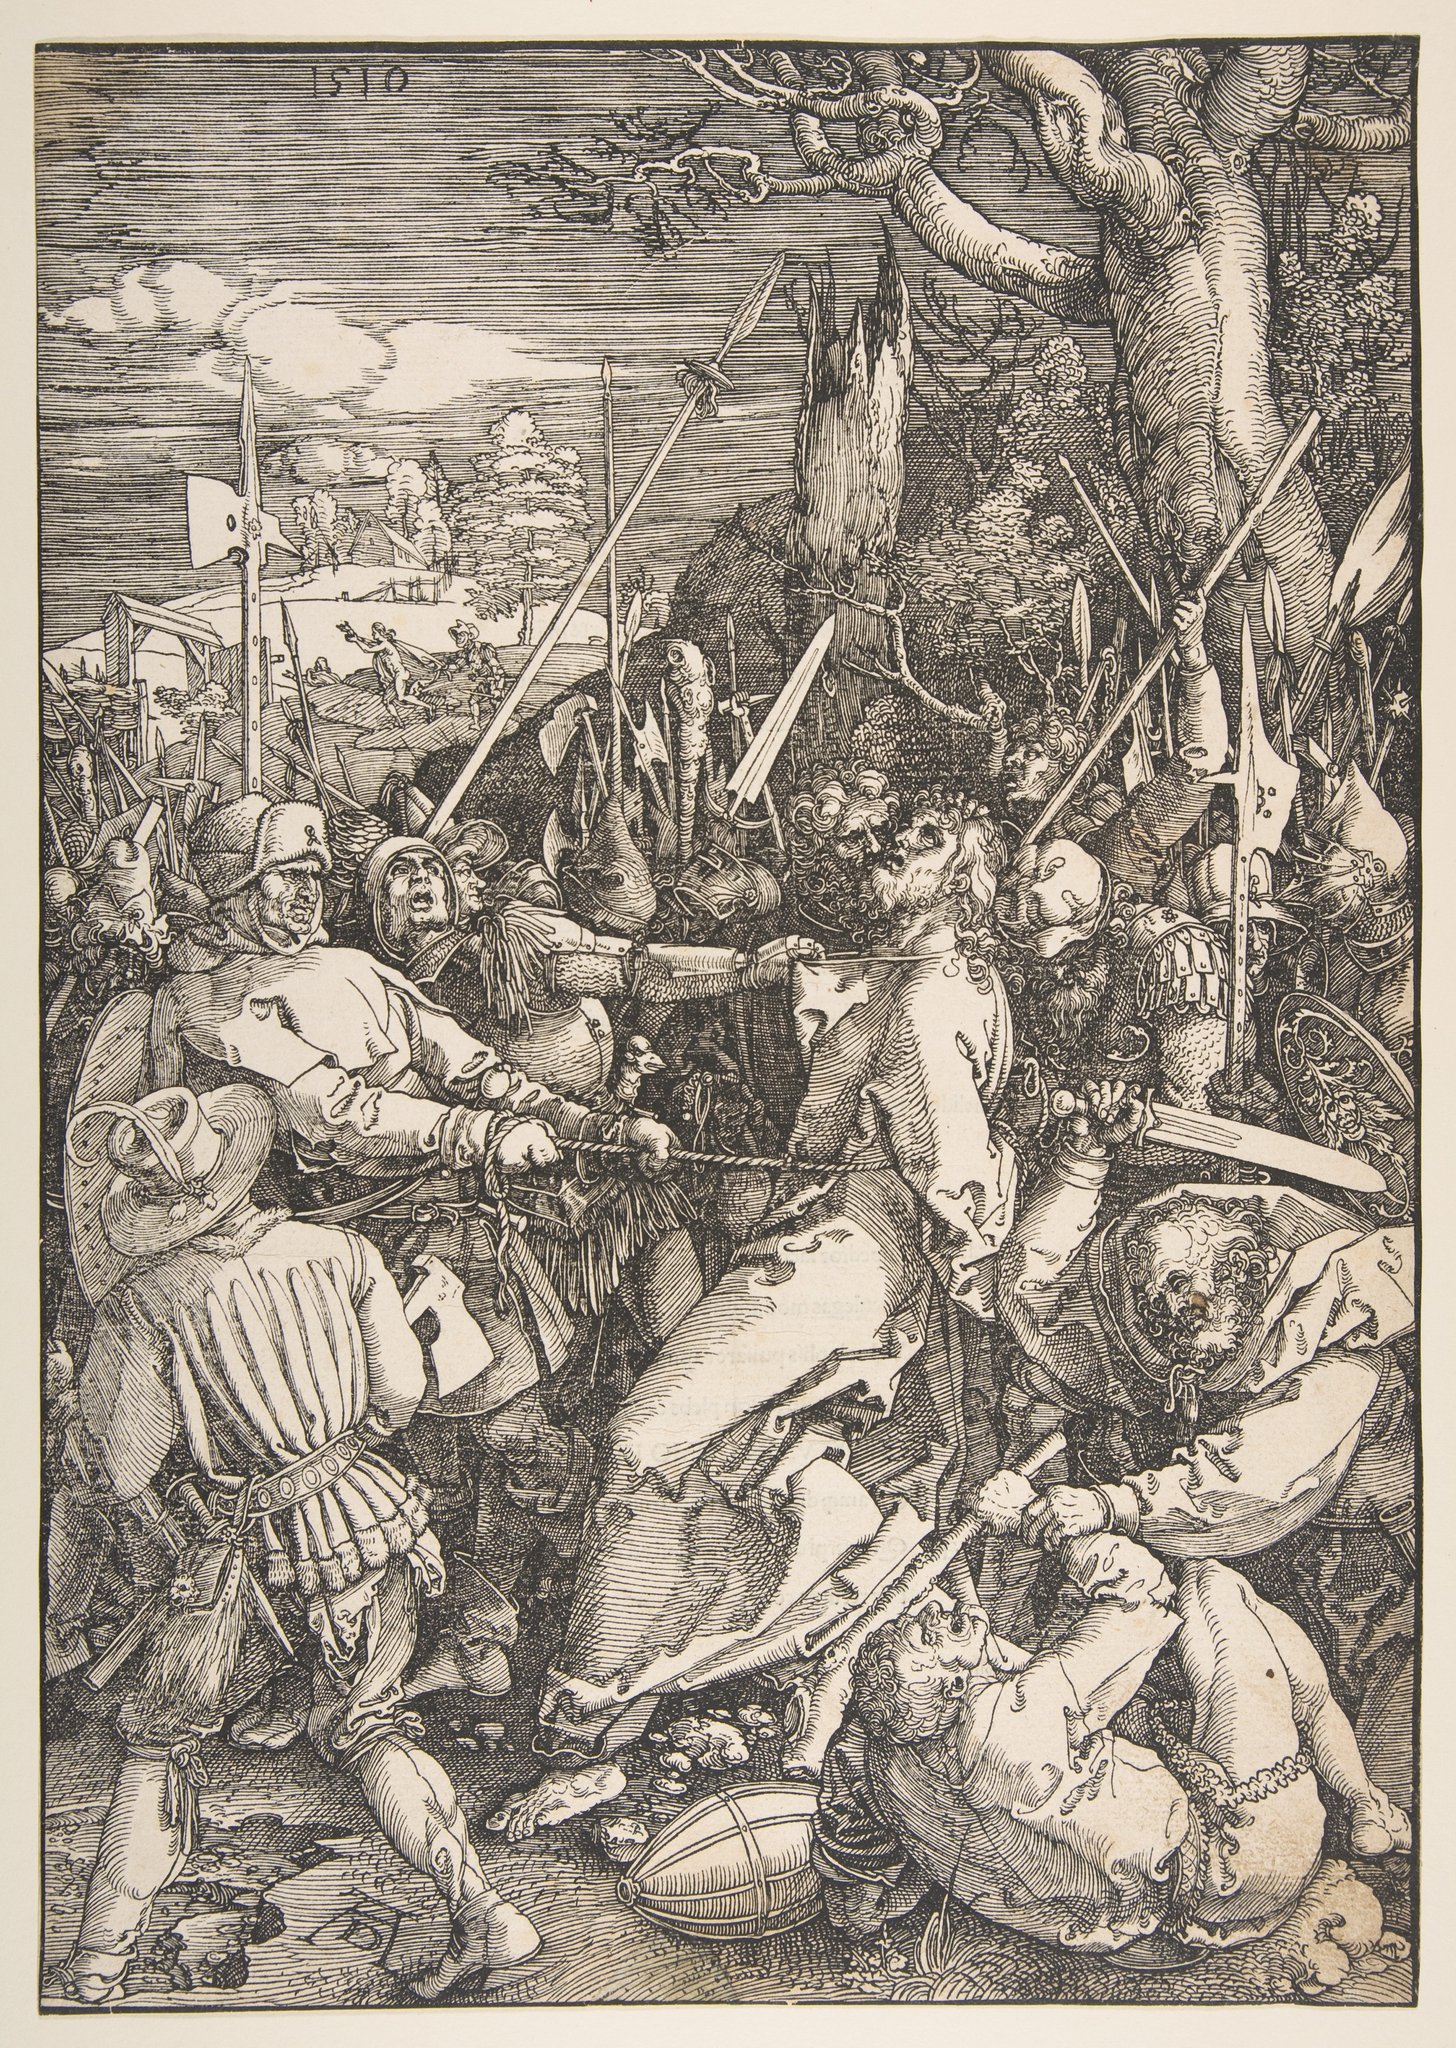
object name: print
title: The Betrayal of Christ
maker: albrecht dürer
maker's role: artist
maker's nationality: german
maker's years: 1471-1528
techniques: woodcut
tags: weapons,men,christ,crowd